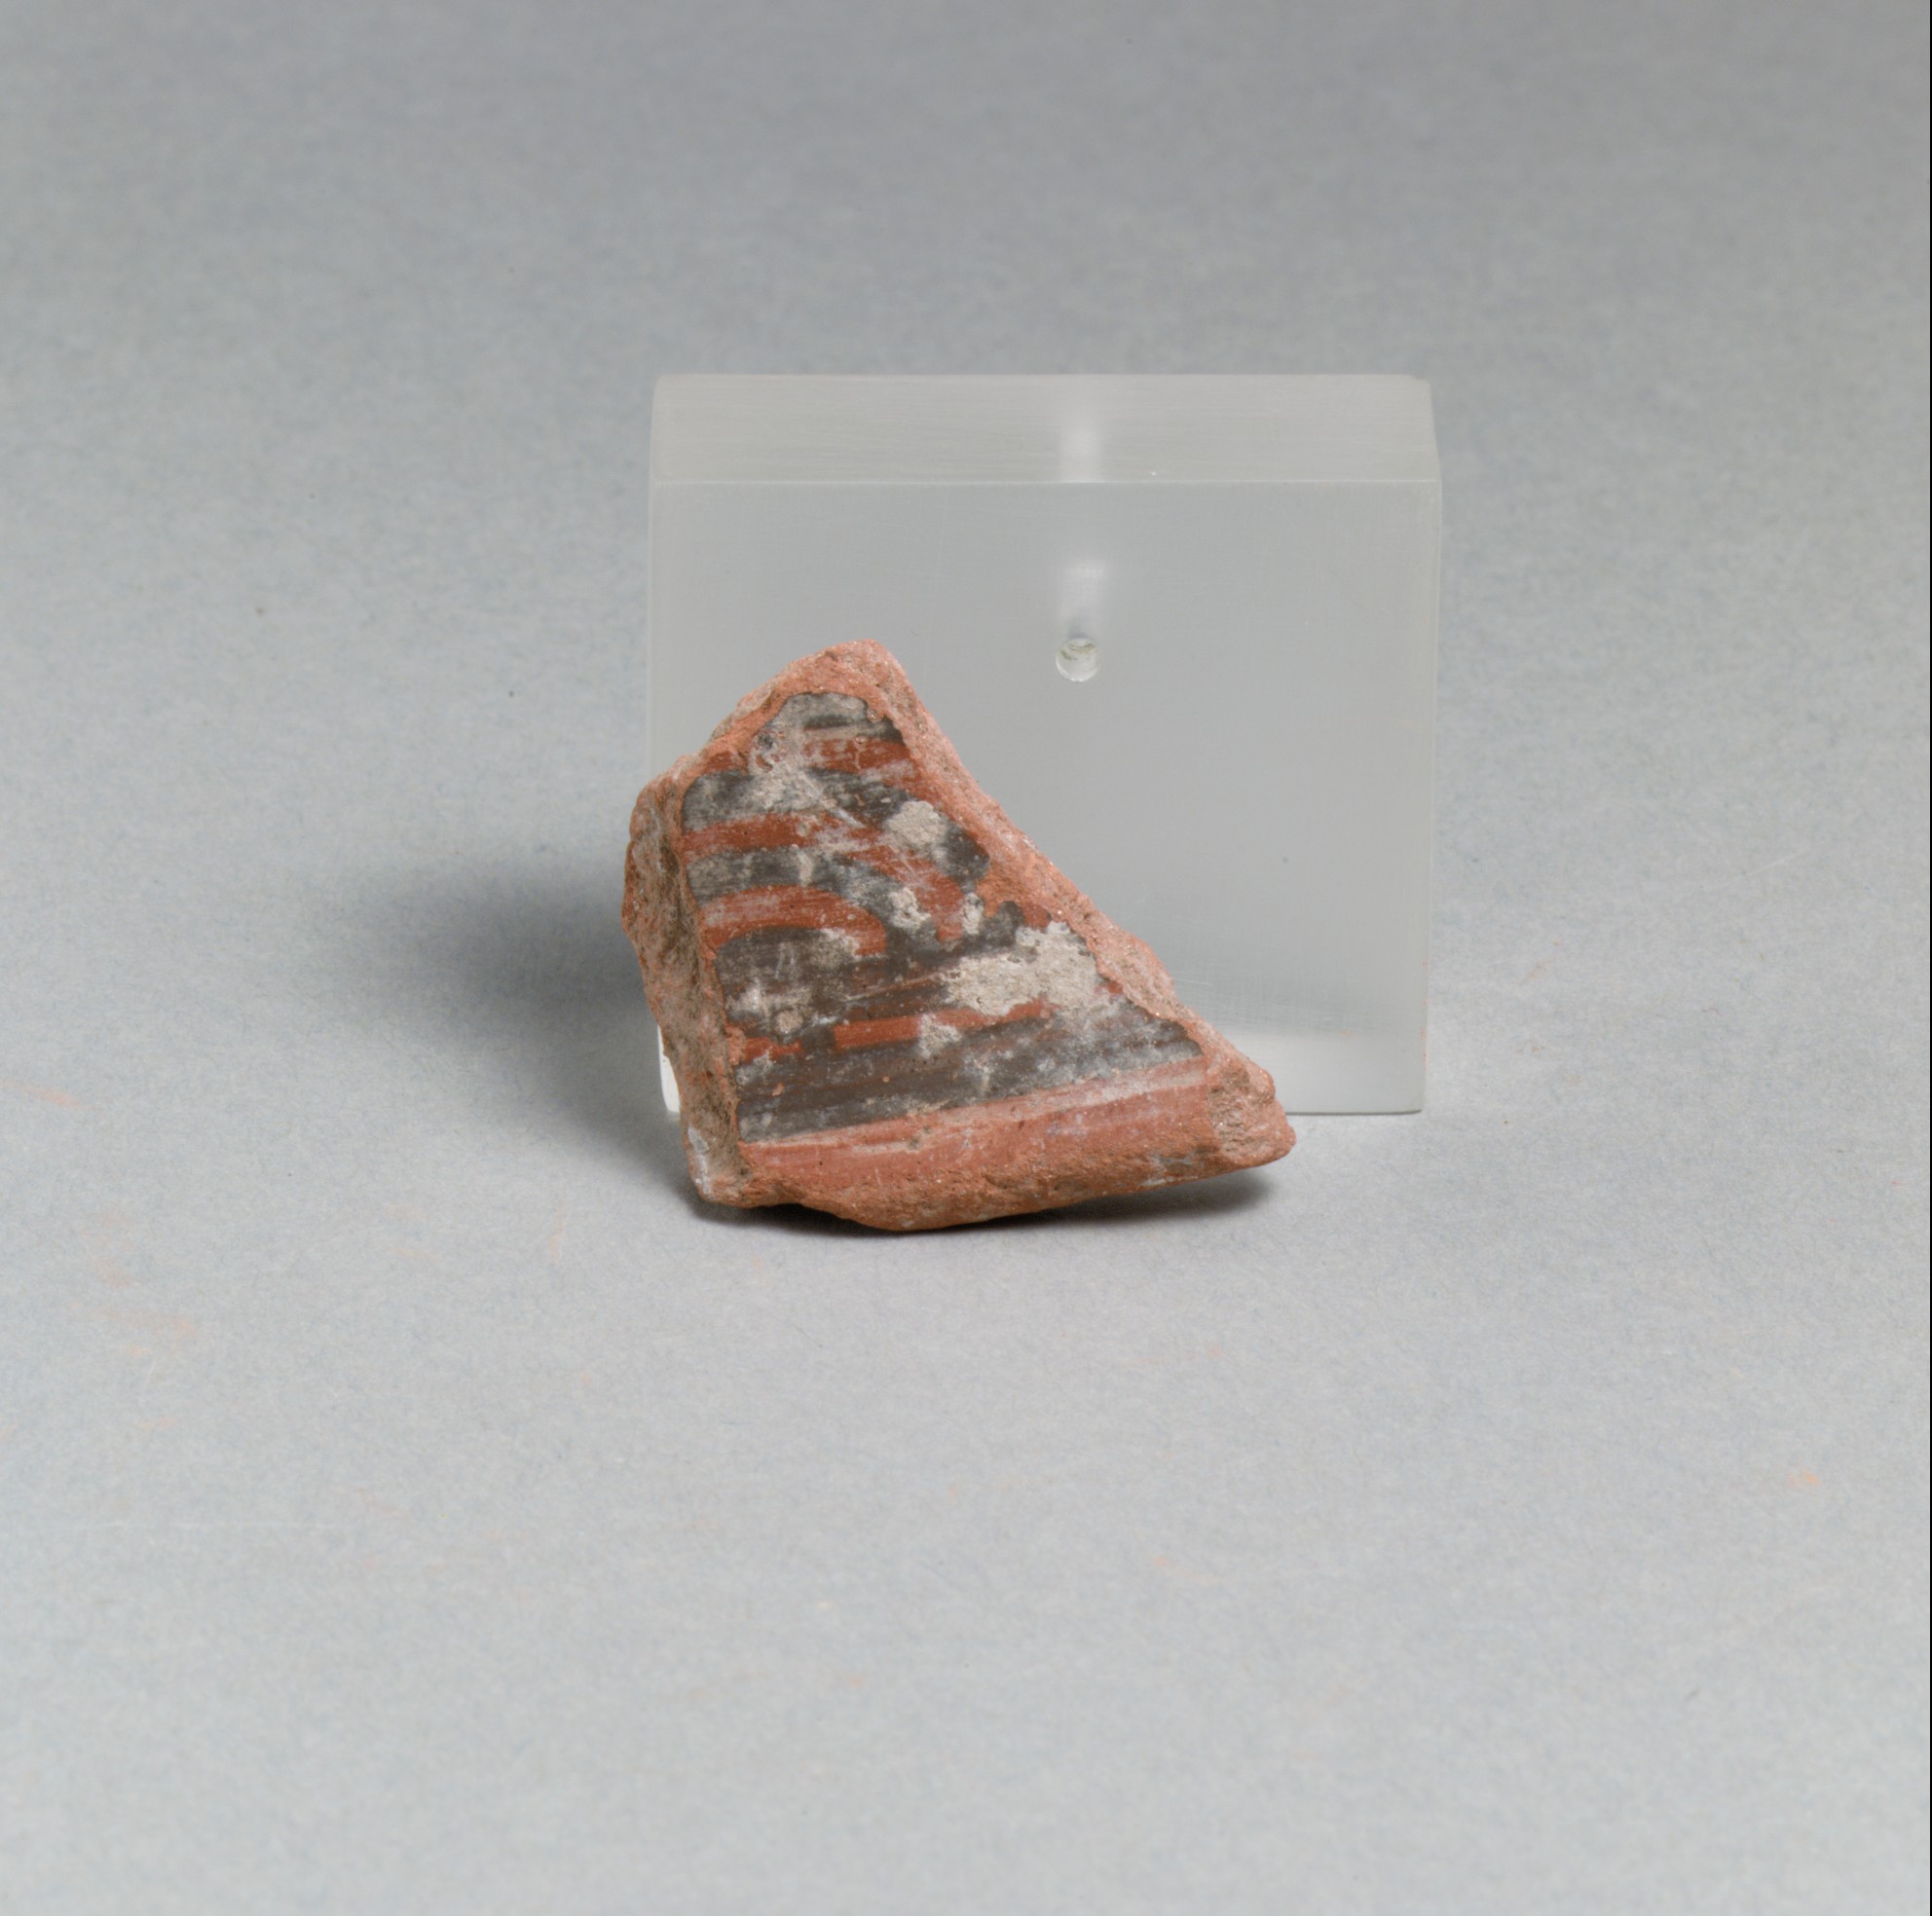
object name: vase fragment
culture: greek or lydian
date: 1050-700 BCE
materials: terracotta